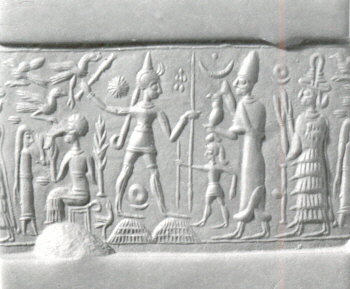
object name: cylinder seal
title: Cylinder seal and modern impression: smiting weather god before king and goddess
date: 1720-1650 BCE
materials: mineral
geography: syria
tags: birds,kings,goddess